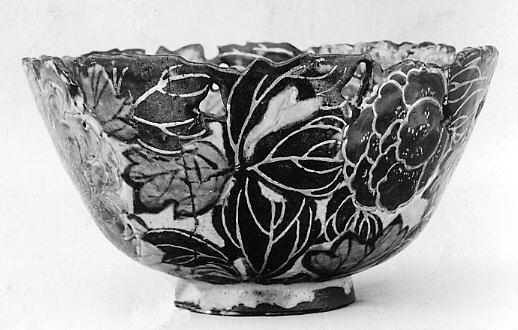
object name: bowl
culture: japanese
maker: makazu kōsai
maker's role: artist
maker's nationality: japanese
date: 1701-1800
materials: enamel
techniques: polychrome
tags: flowers,leaves